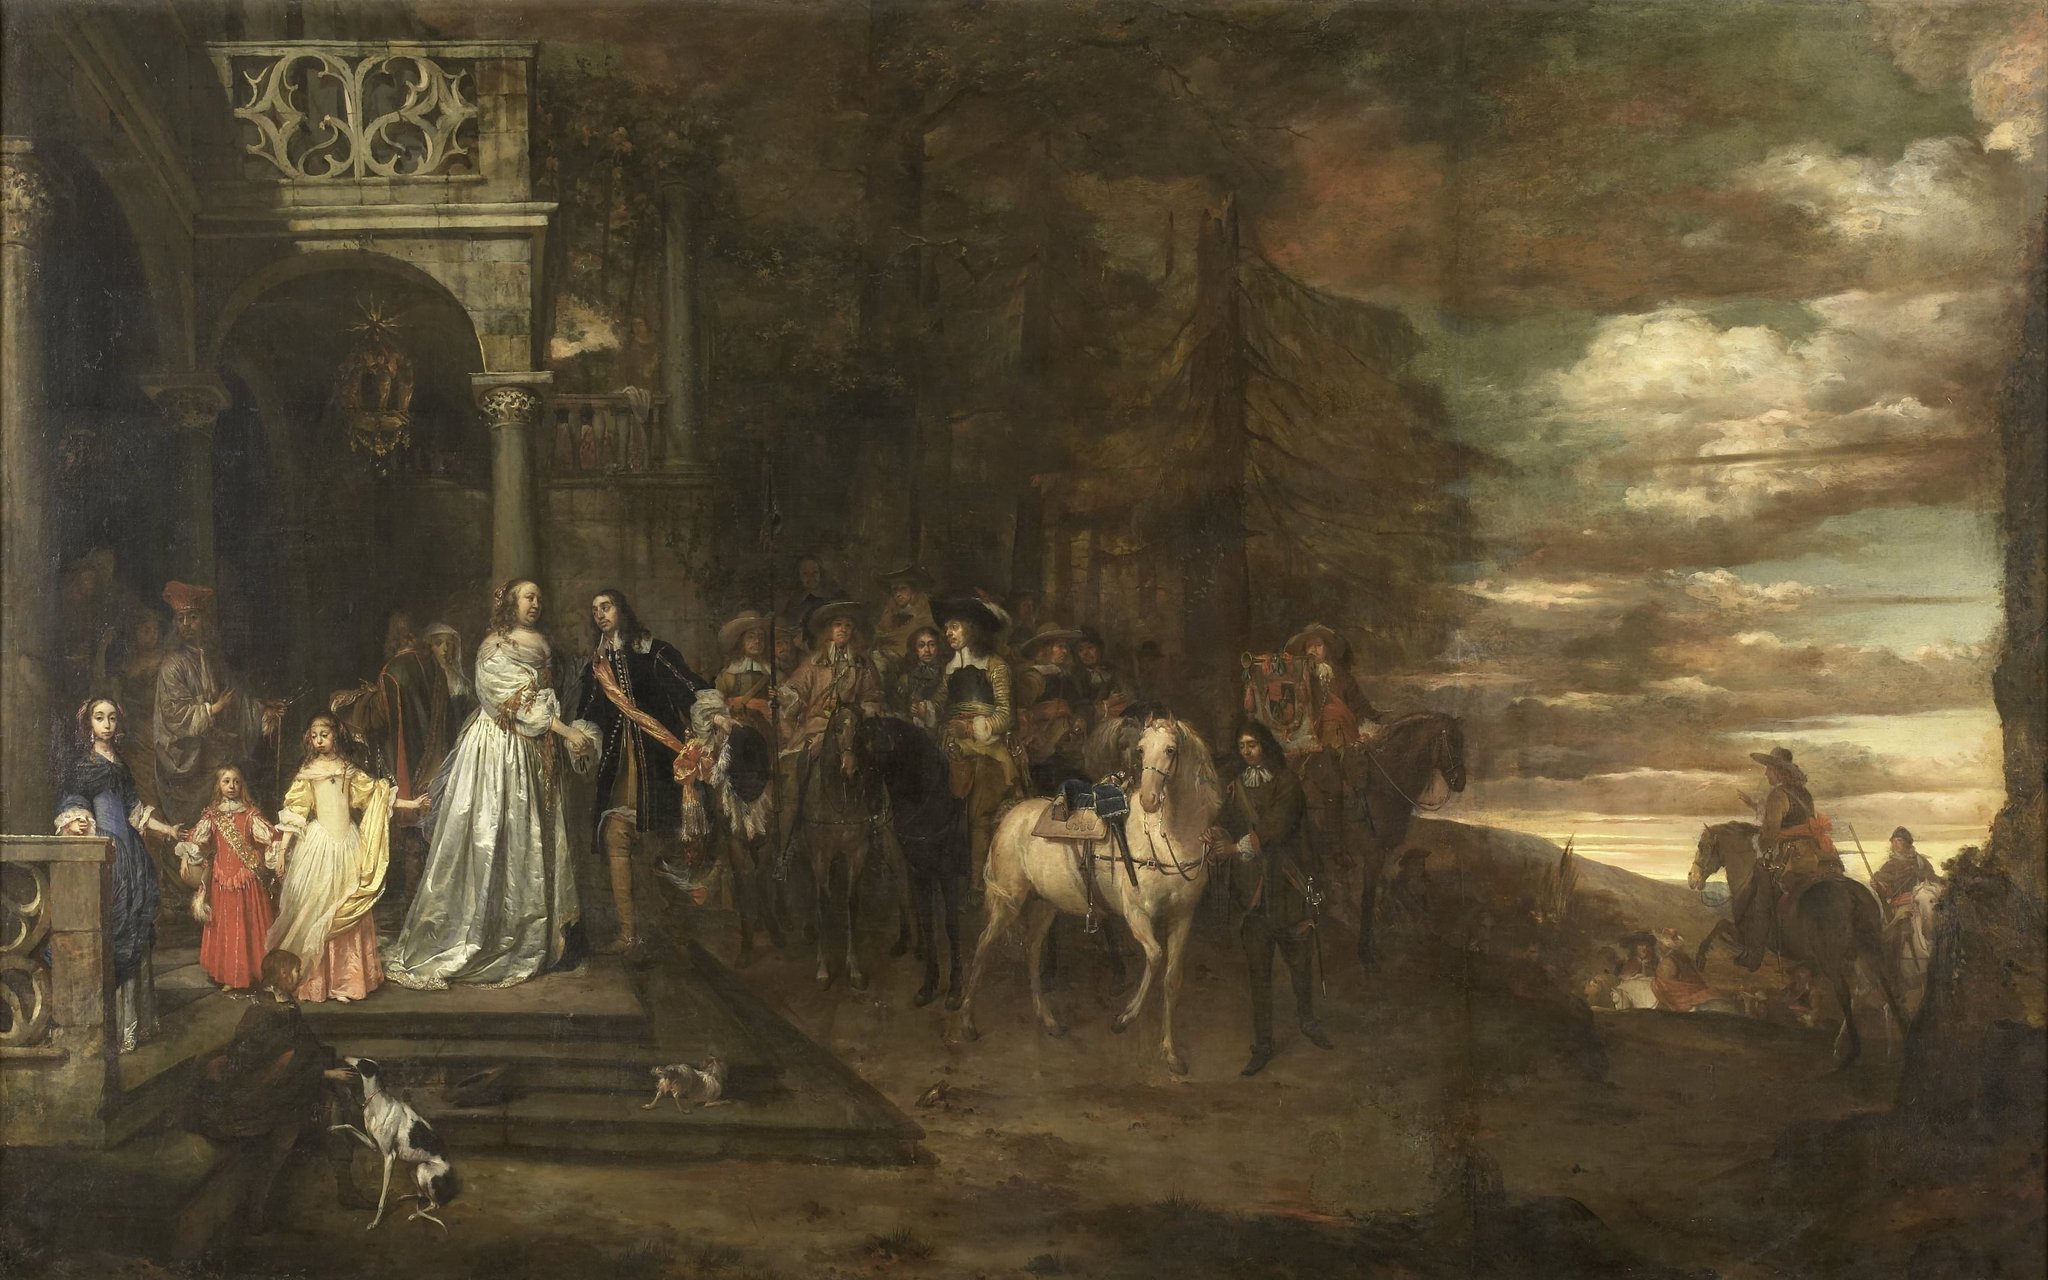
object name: painting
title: The Leavetaking of Captain Hendrik de Sandra (1619-1707), sent off by his Wife and Children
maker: pieter van anraedt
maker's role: painter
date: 1661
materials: canvas, oil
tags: painter, pieter van anraedt, leiden, amsterdam, maarssen, riding a horse, ass, or mule; rider, horseman, family group, especially parents with their child(ren), historical persons, portrait, self-portrait of painter, portrait, self-portrait of artist, waving farewell ~ departure on a journey, taking leave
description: Ritmeester Hendrik de Sandra neemt voor zijn woning afscheid van zijn vrouw Margareta Tortarolis en de kinderen Anna Maria de Sandra, Margareta Barbara de Sandra en Henricus Johannes De Sandra. Rechts een groep ruiters. Tussen het personeel ook een zelfportret van de schilder Pieter van Anraedt.